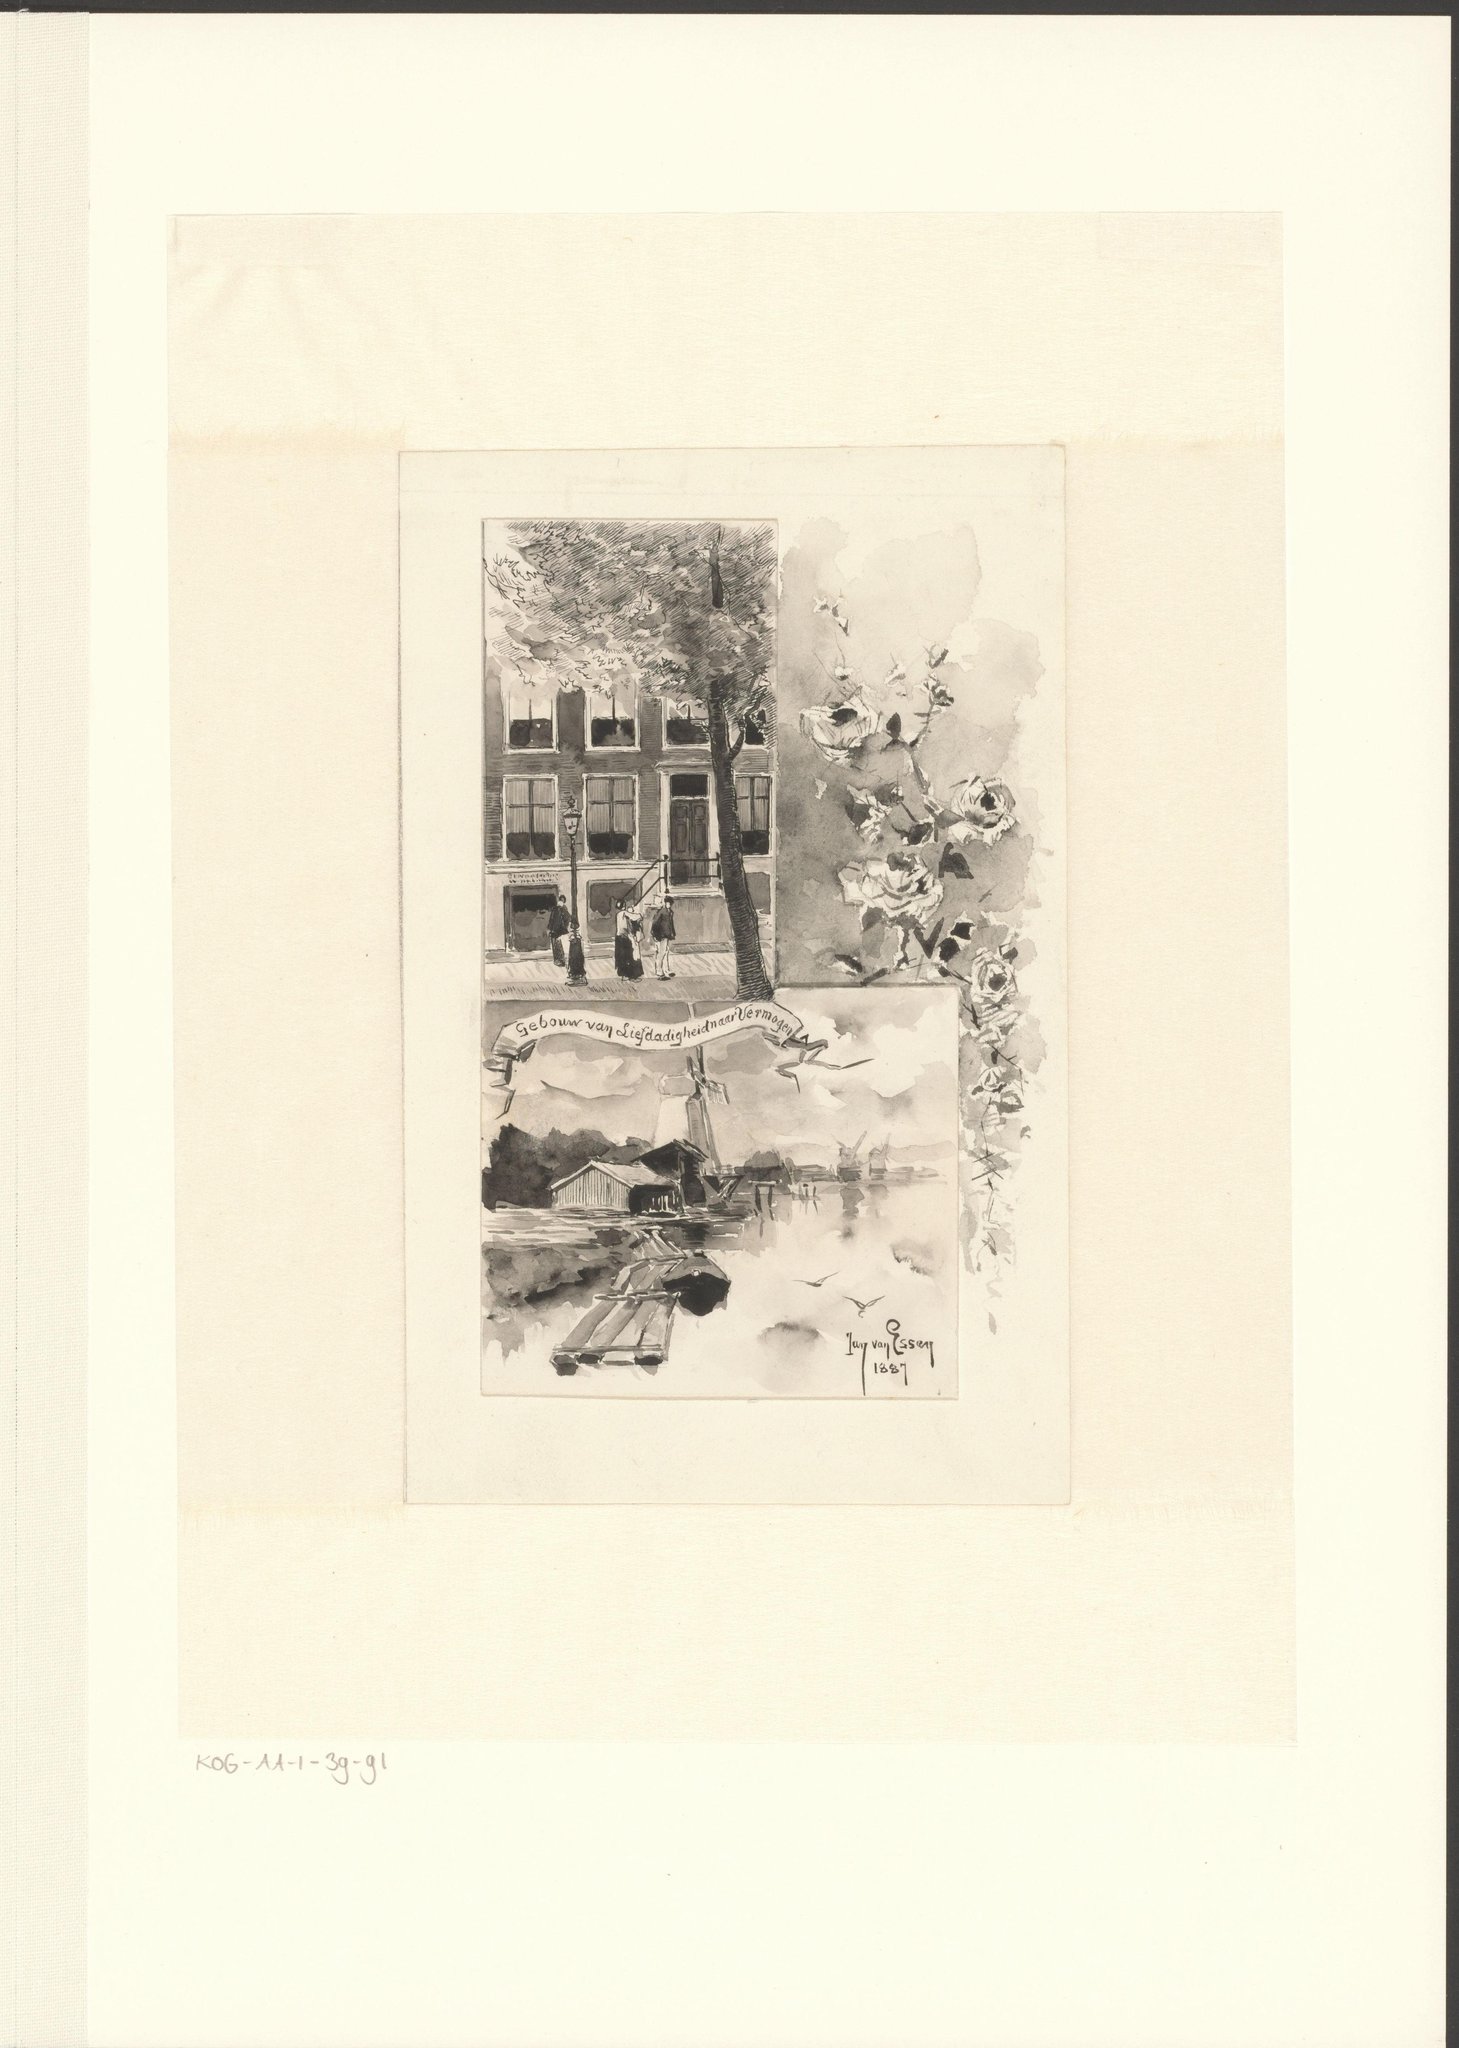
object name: drawing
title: Gezicht op het gebouw van het Genootschap Liefdadigheid naar Vermogen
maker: jan van essen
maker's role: draughtsman, print maker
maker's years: 1854-1936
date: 1887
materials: ink, paper, pencil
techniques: brush, pen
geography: amsterdam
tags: city-view in general; 'veduta', river, windmill in landscape, façade (of house or building), street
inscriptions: signature and date: ‘Jan van Essen / 1887’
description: Onderwerpsrubriek binnen de Atlas Amsterdam: Liefdadigheid naar Vermogen.